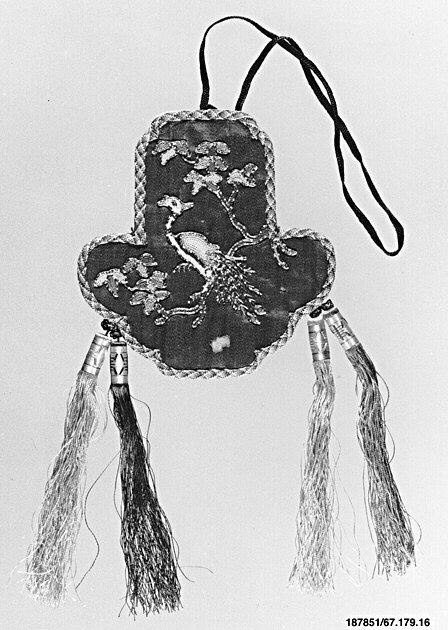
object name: purse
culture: chinese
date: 1801-1900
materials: metal thread, silk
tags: birds